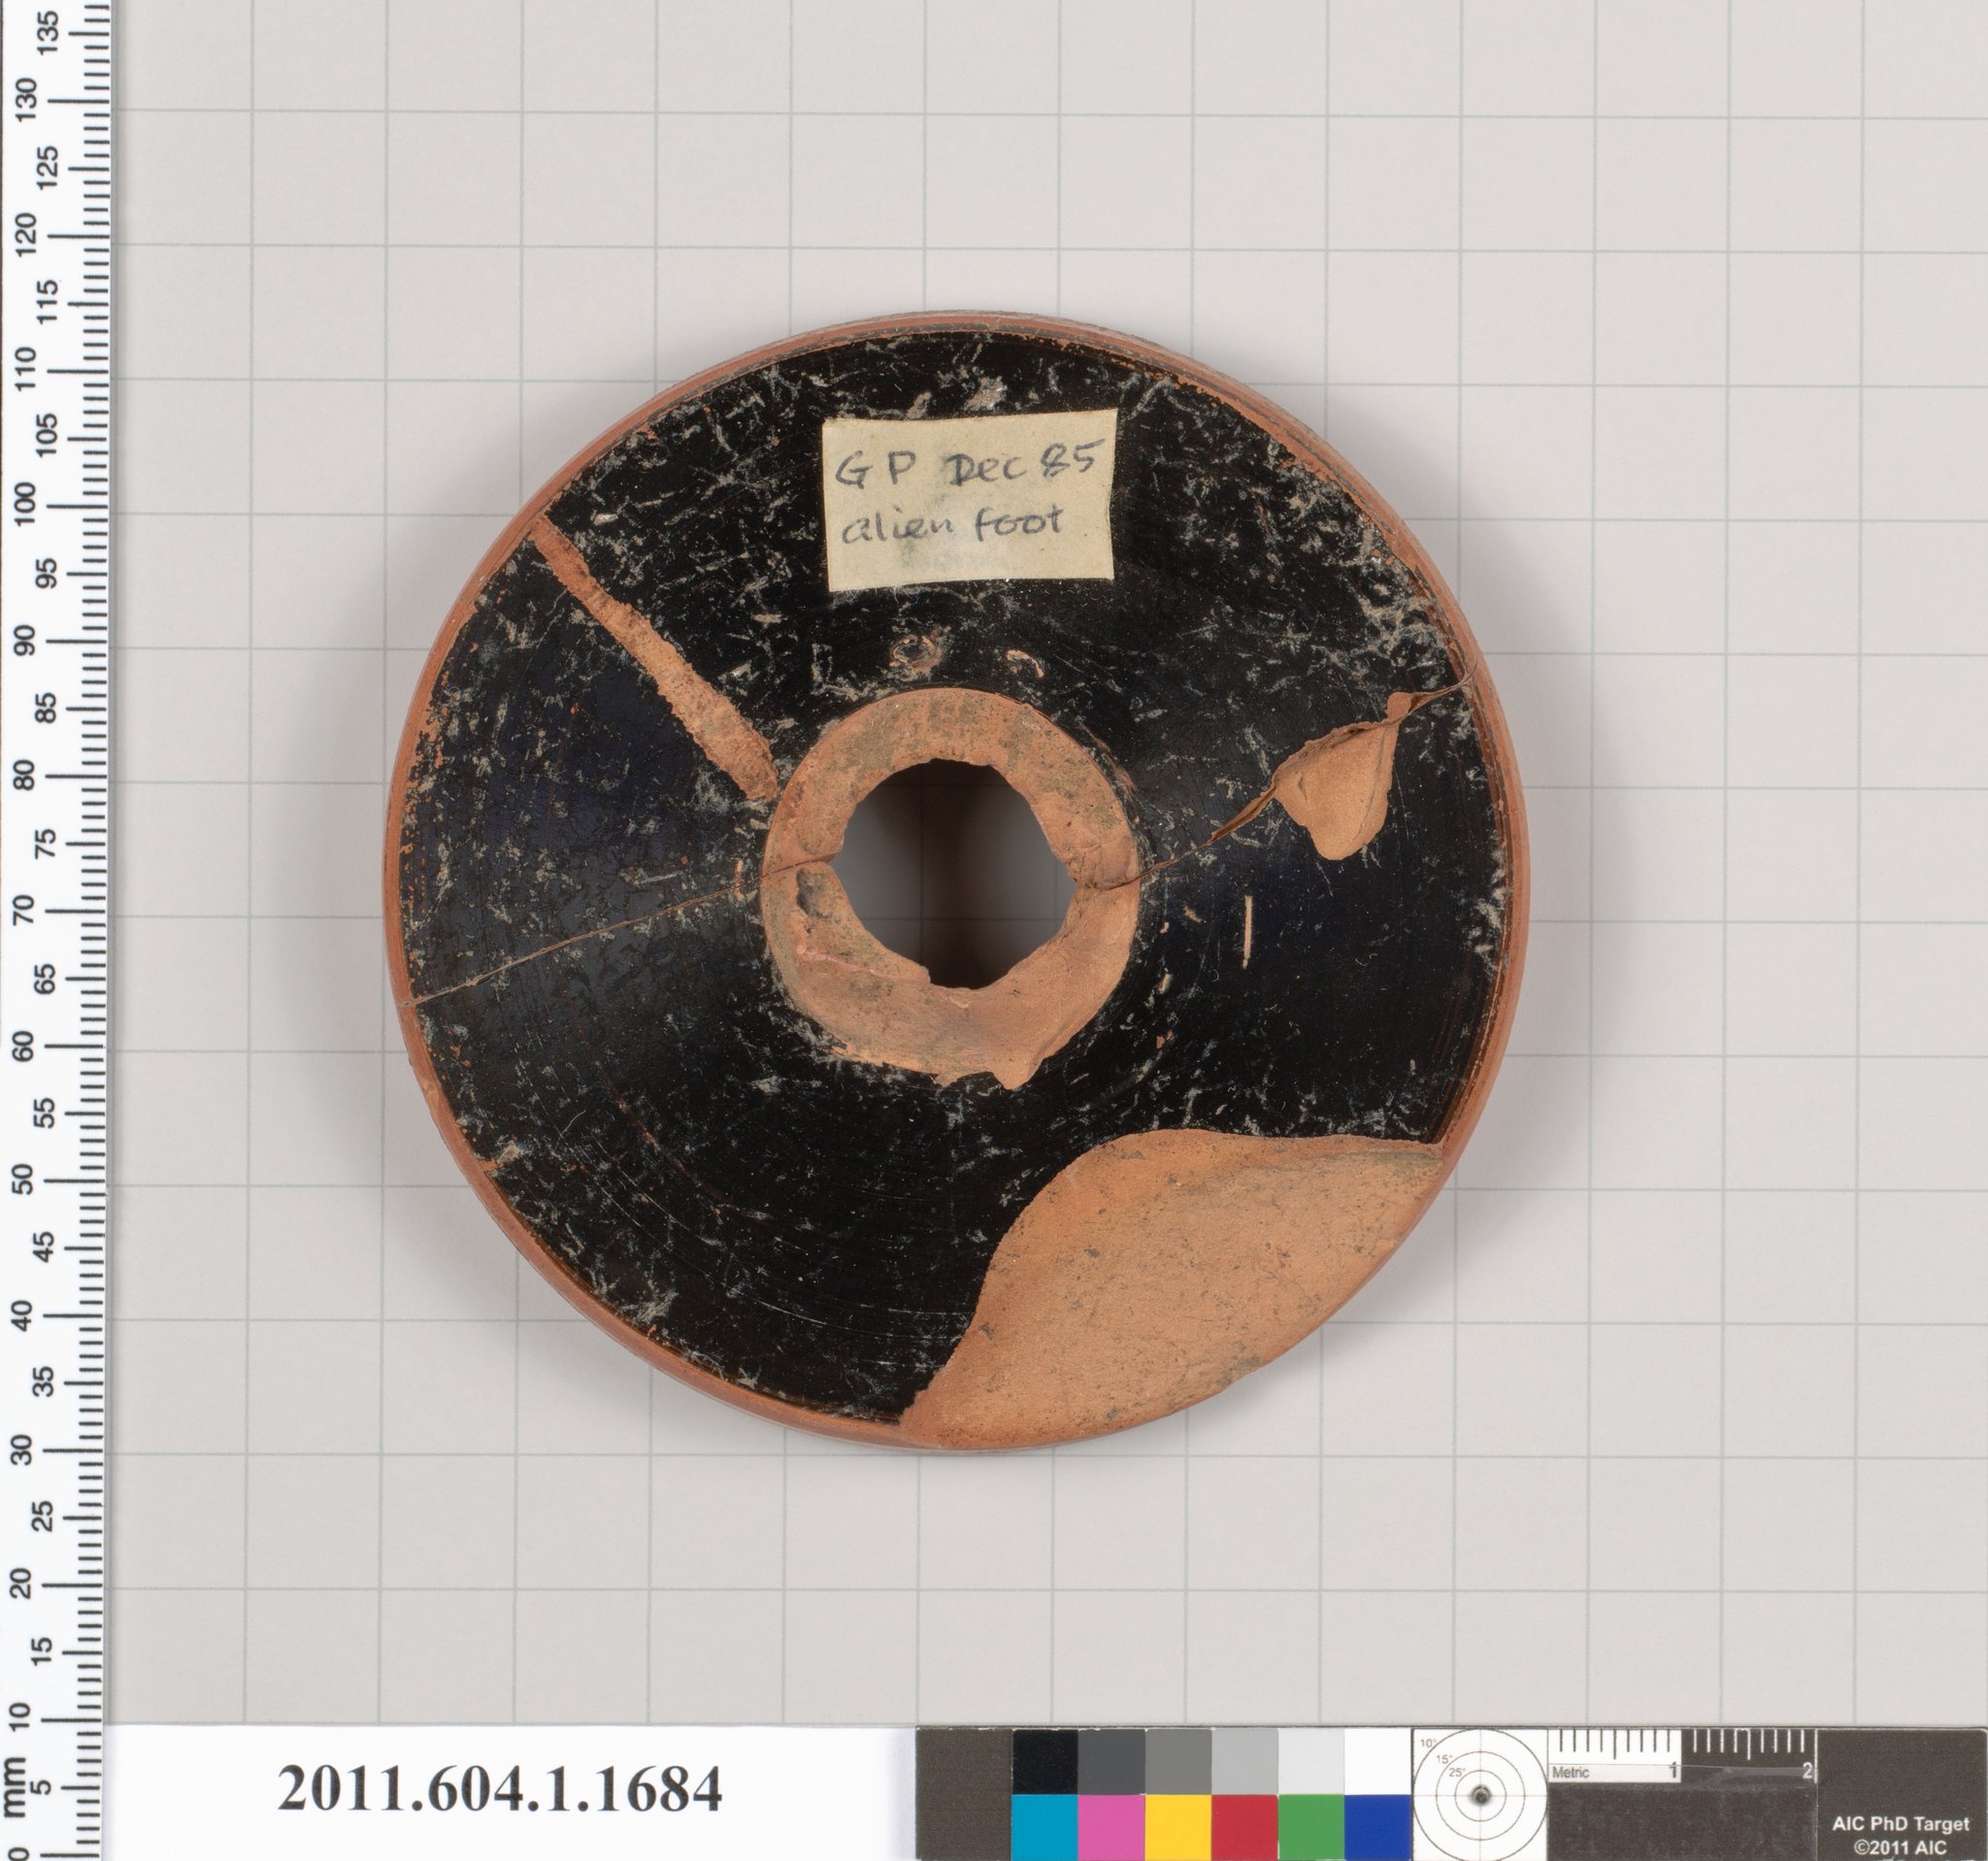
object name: kylix fragment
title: Terracotta fragment of a kylix (drinking cup)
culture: greek, attic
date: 500-401 BCE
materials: terracotta